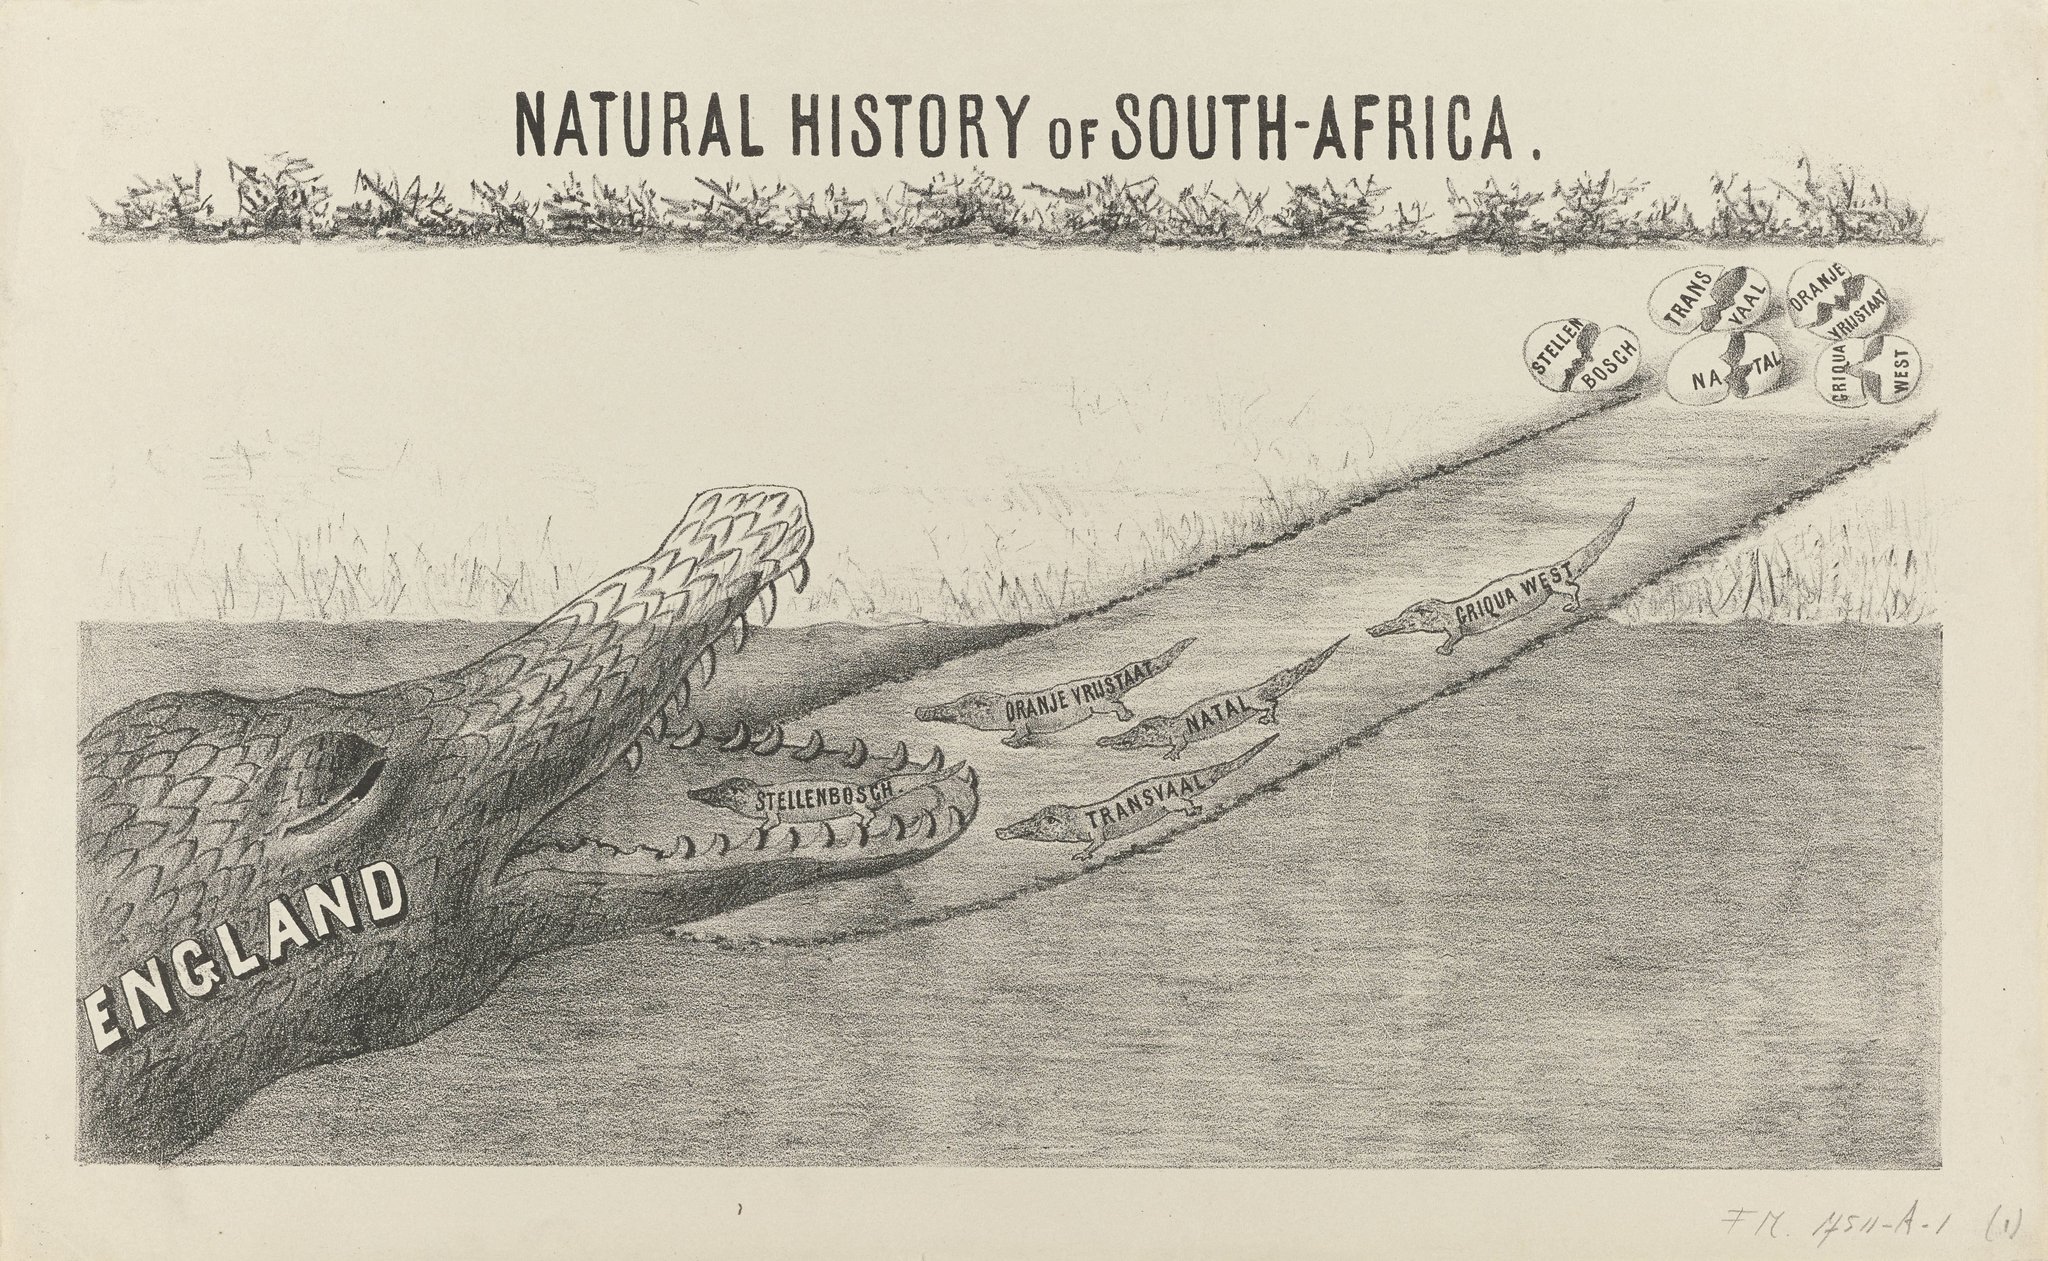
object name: print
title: Annexation of the Transvaal / by an African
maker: Anonymous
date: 1877-1880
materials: paper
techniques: lithograph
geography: south africa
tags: crocodiles: crocodile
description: De Engelse krokodil eet haar eigen nakomeligen die net uit de eieren zijn gekropen op. De vijf kleine krokodillen zijn genaamd: Stellenbosch, Transvaal, Oranje Vrijstaat, Natal, Griqua West. Onderdeel van de serie van elf spotprenten op de Britse annexatie van Transvaal in 1877.